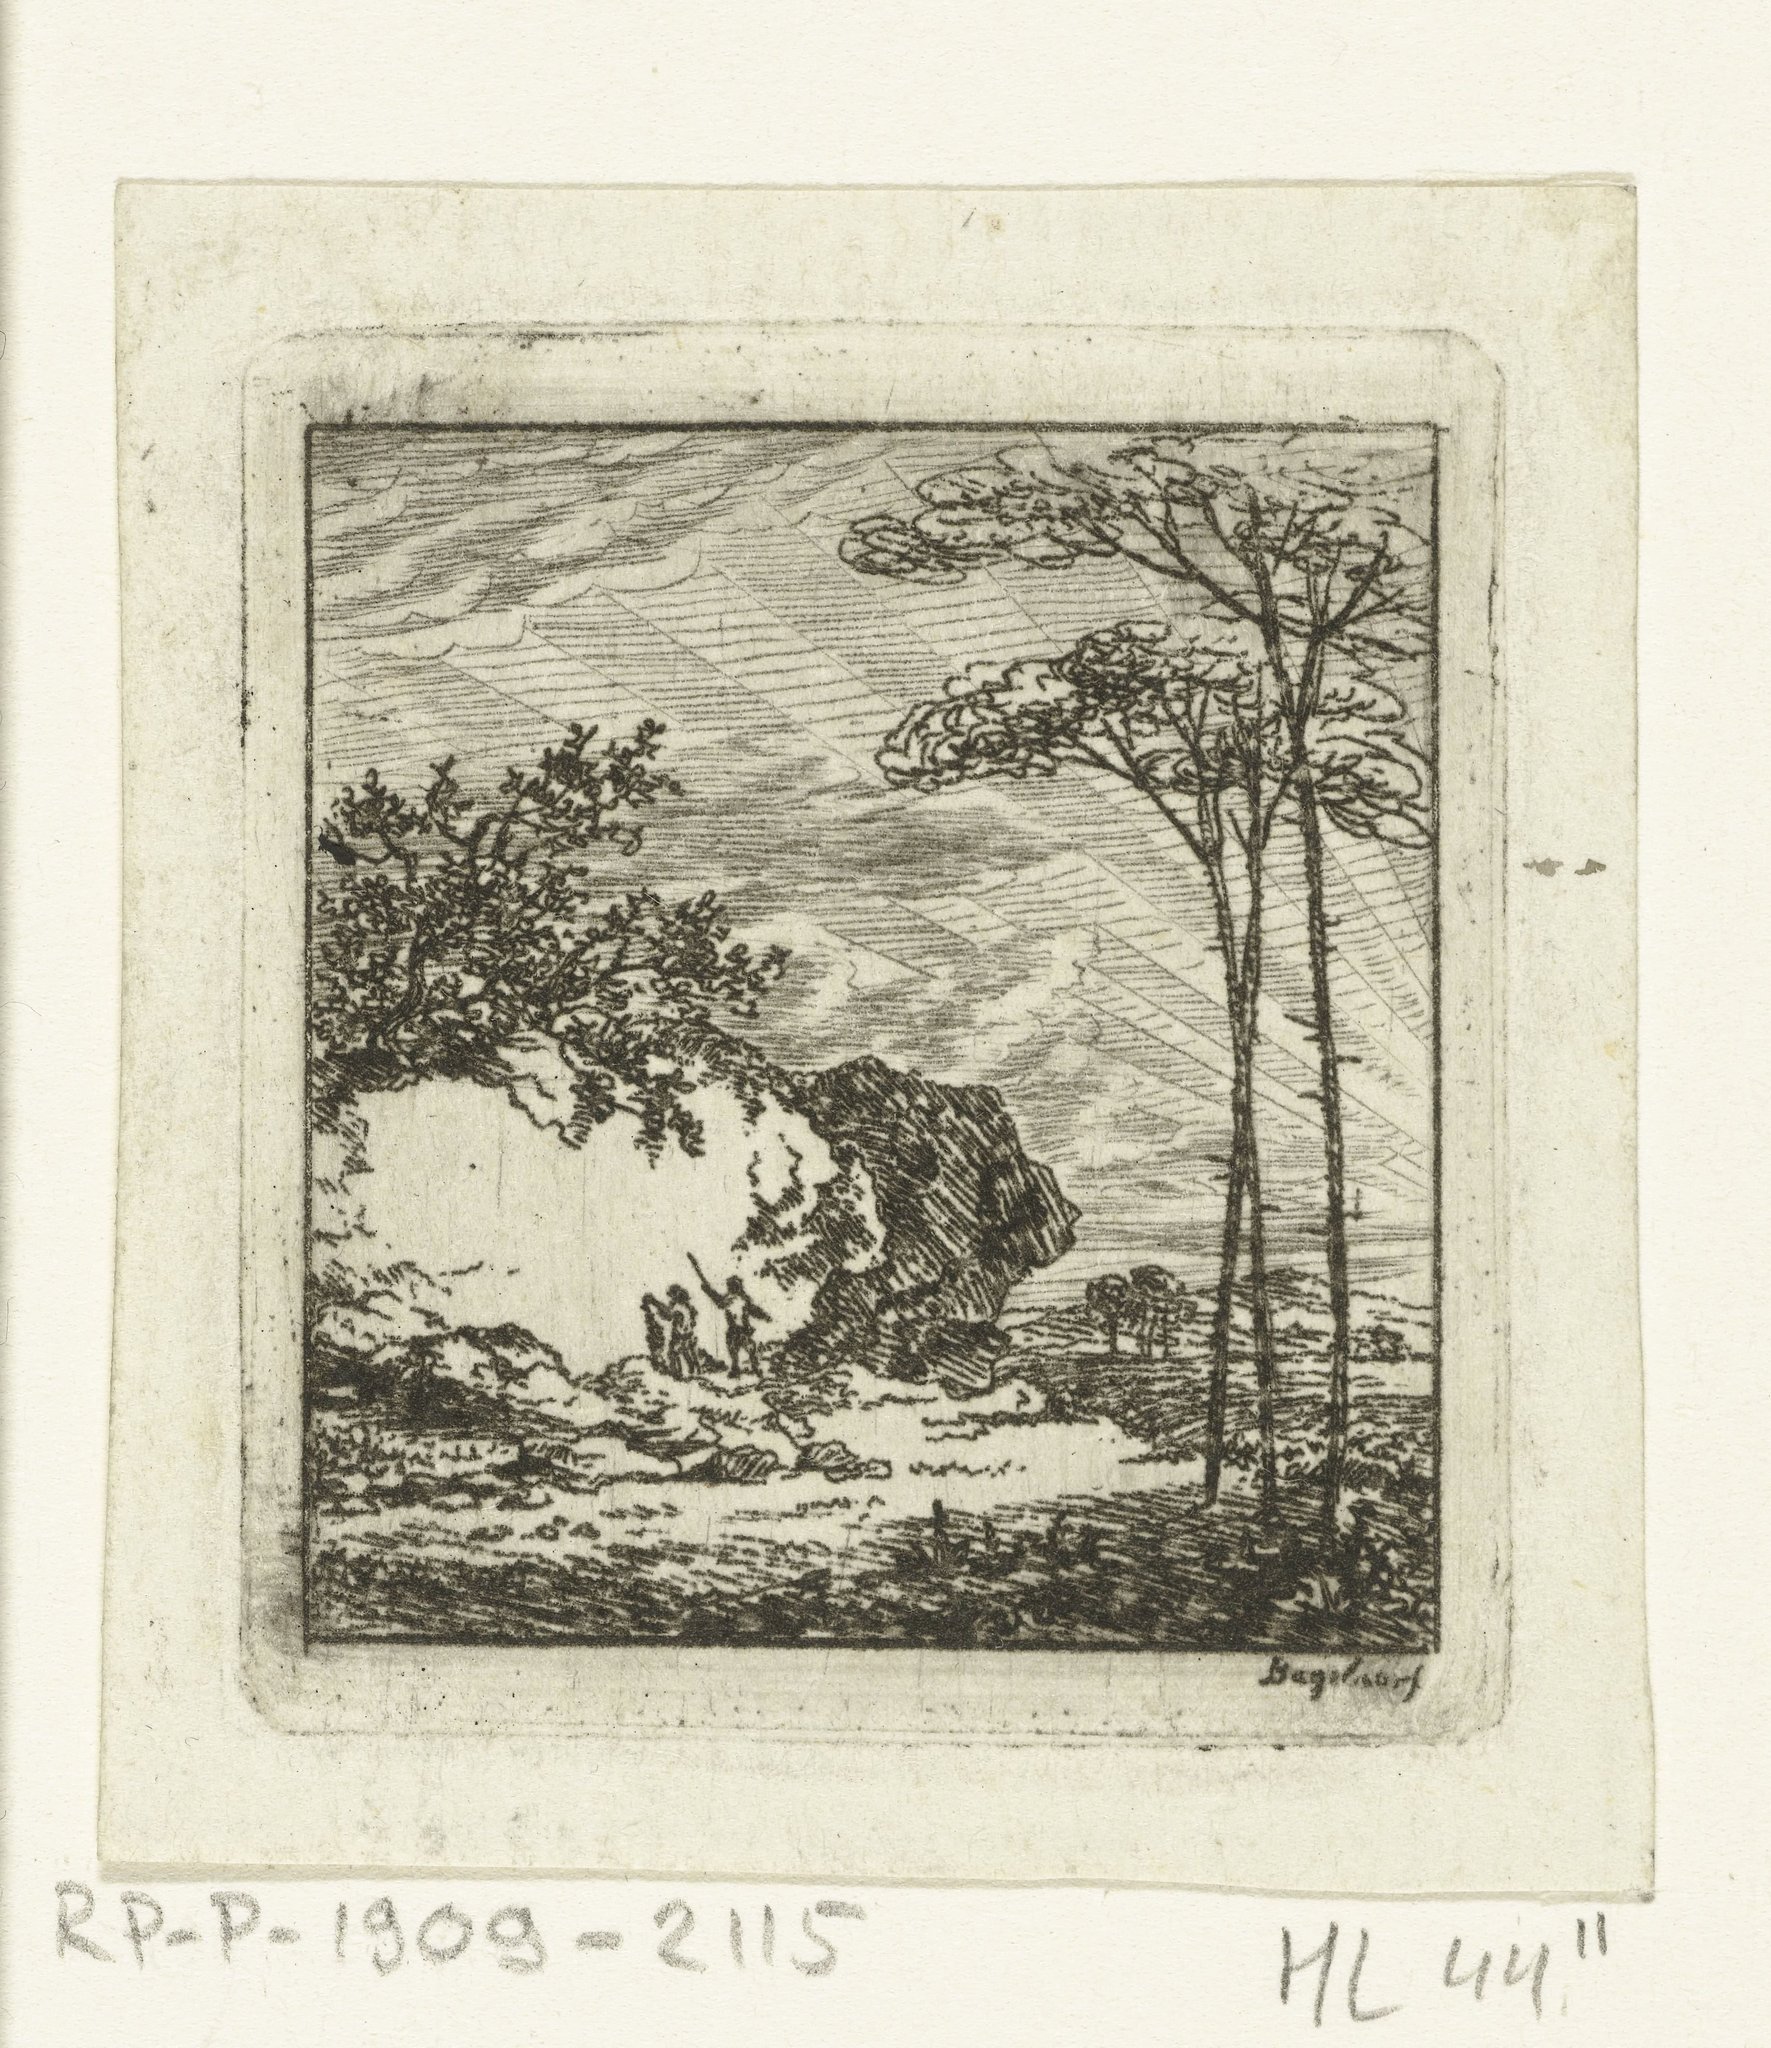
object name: print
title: Rotslandschap met twee mannen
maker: ernst willem jan bagelaar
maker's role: draughtsman, print maker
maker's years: 1775-1837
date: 1798-1837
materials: paper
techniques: drypoint, etching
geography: netherlands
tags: landscapes in the temperate zone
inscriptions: collector's mark: Lugt 2228